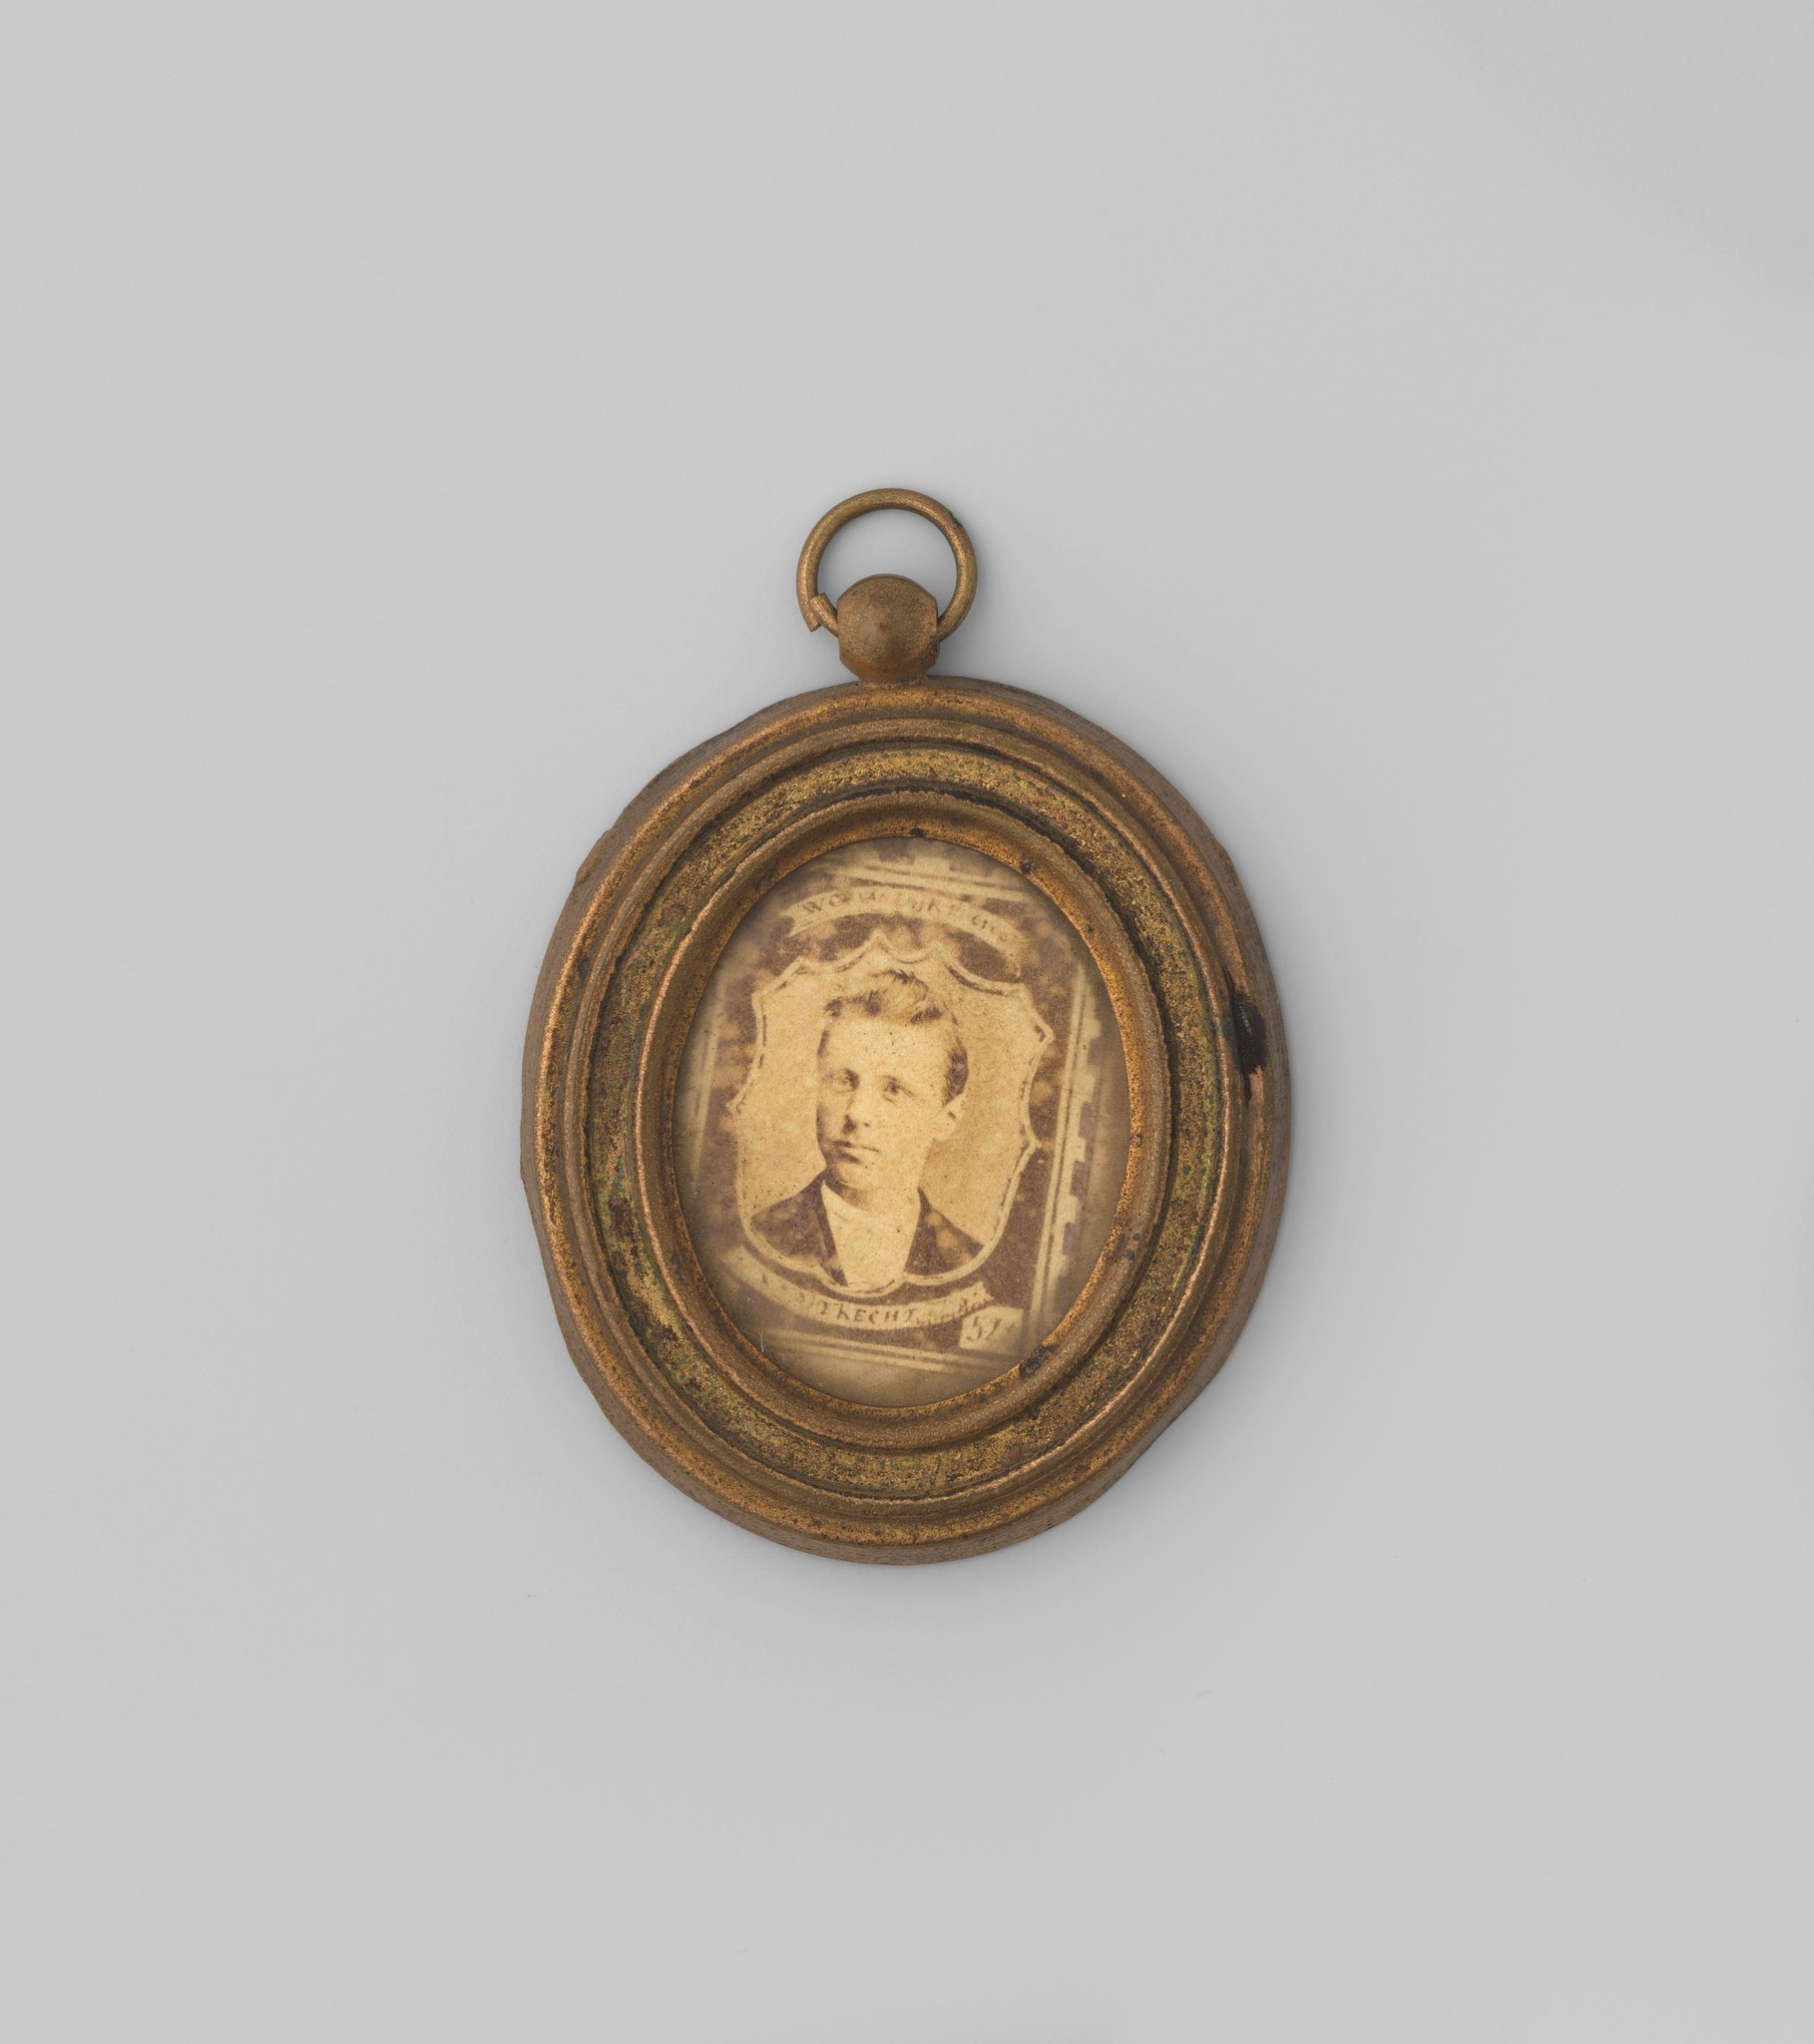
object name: locket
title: Portret van een onbekende jongeman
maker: willem cornelis van dijk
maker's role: painter, print maker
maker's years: 1826-1881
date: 1851-1900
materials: cardboard, glass, metal, paper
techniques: albumen print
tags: historical persons, youth, adolescent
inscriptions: inscription: ‘Utrecht’